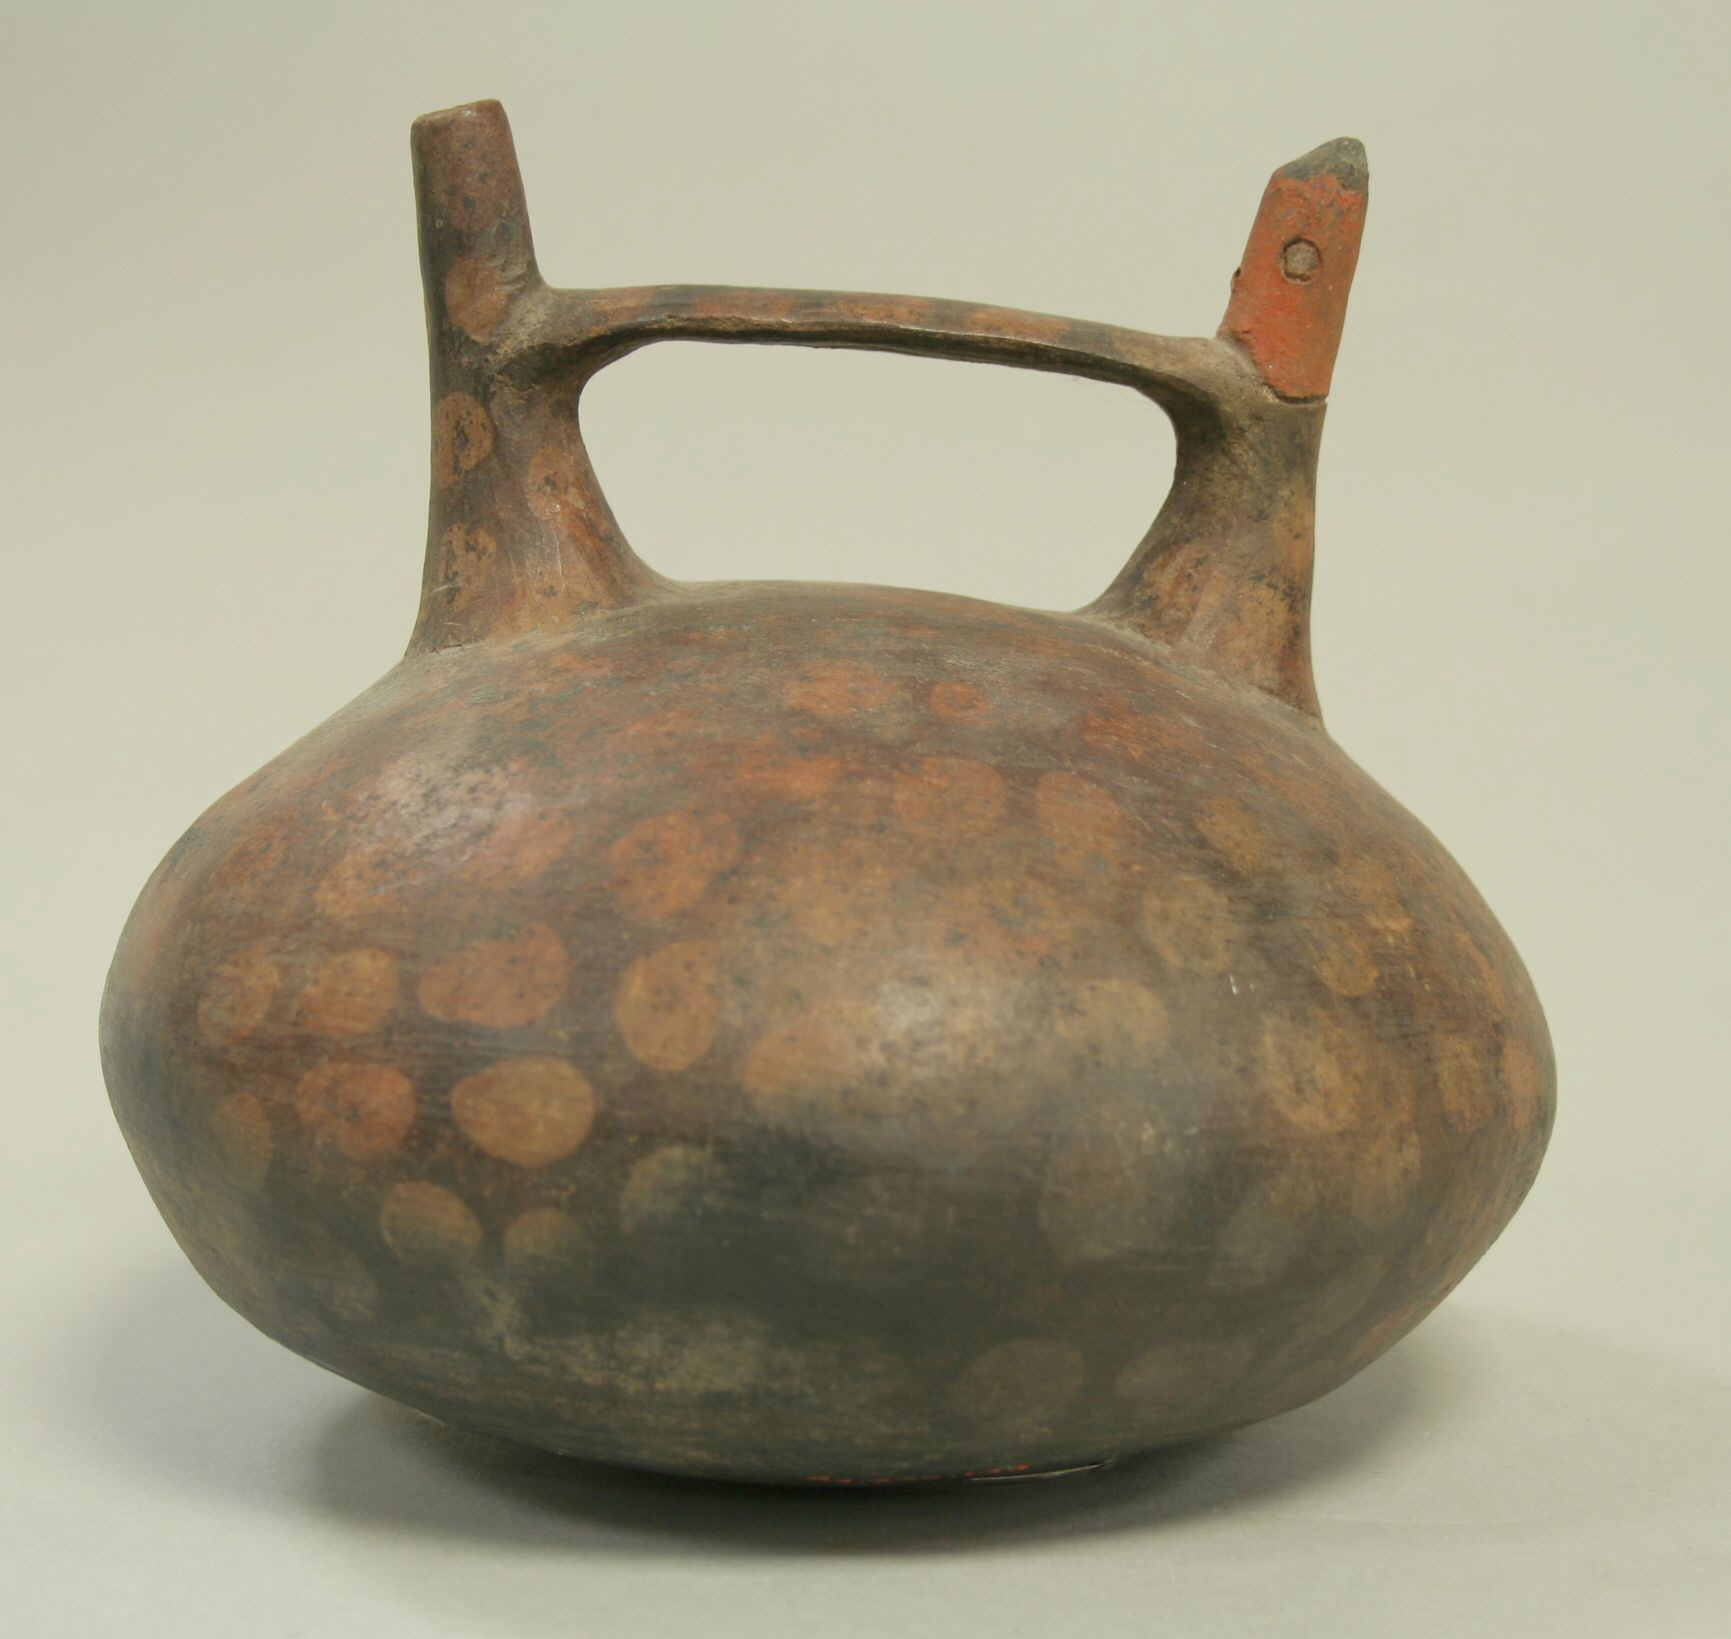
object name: bottle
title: Double Spout and Bridge Bottle with Bird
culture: paracas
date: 500-101 BCE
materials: ceramic, pigment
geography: peru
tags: birds